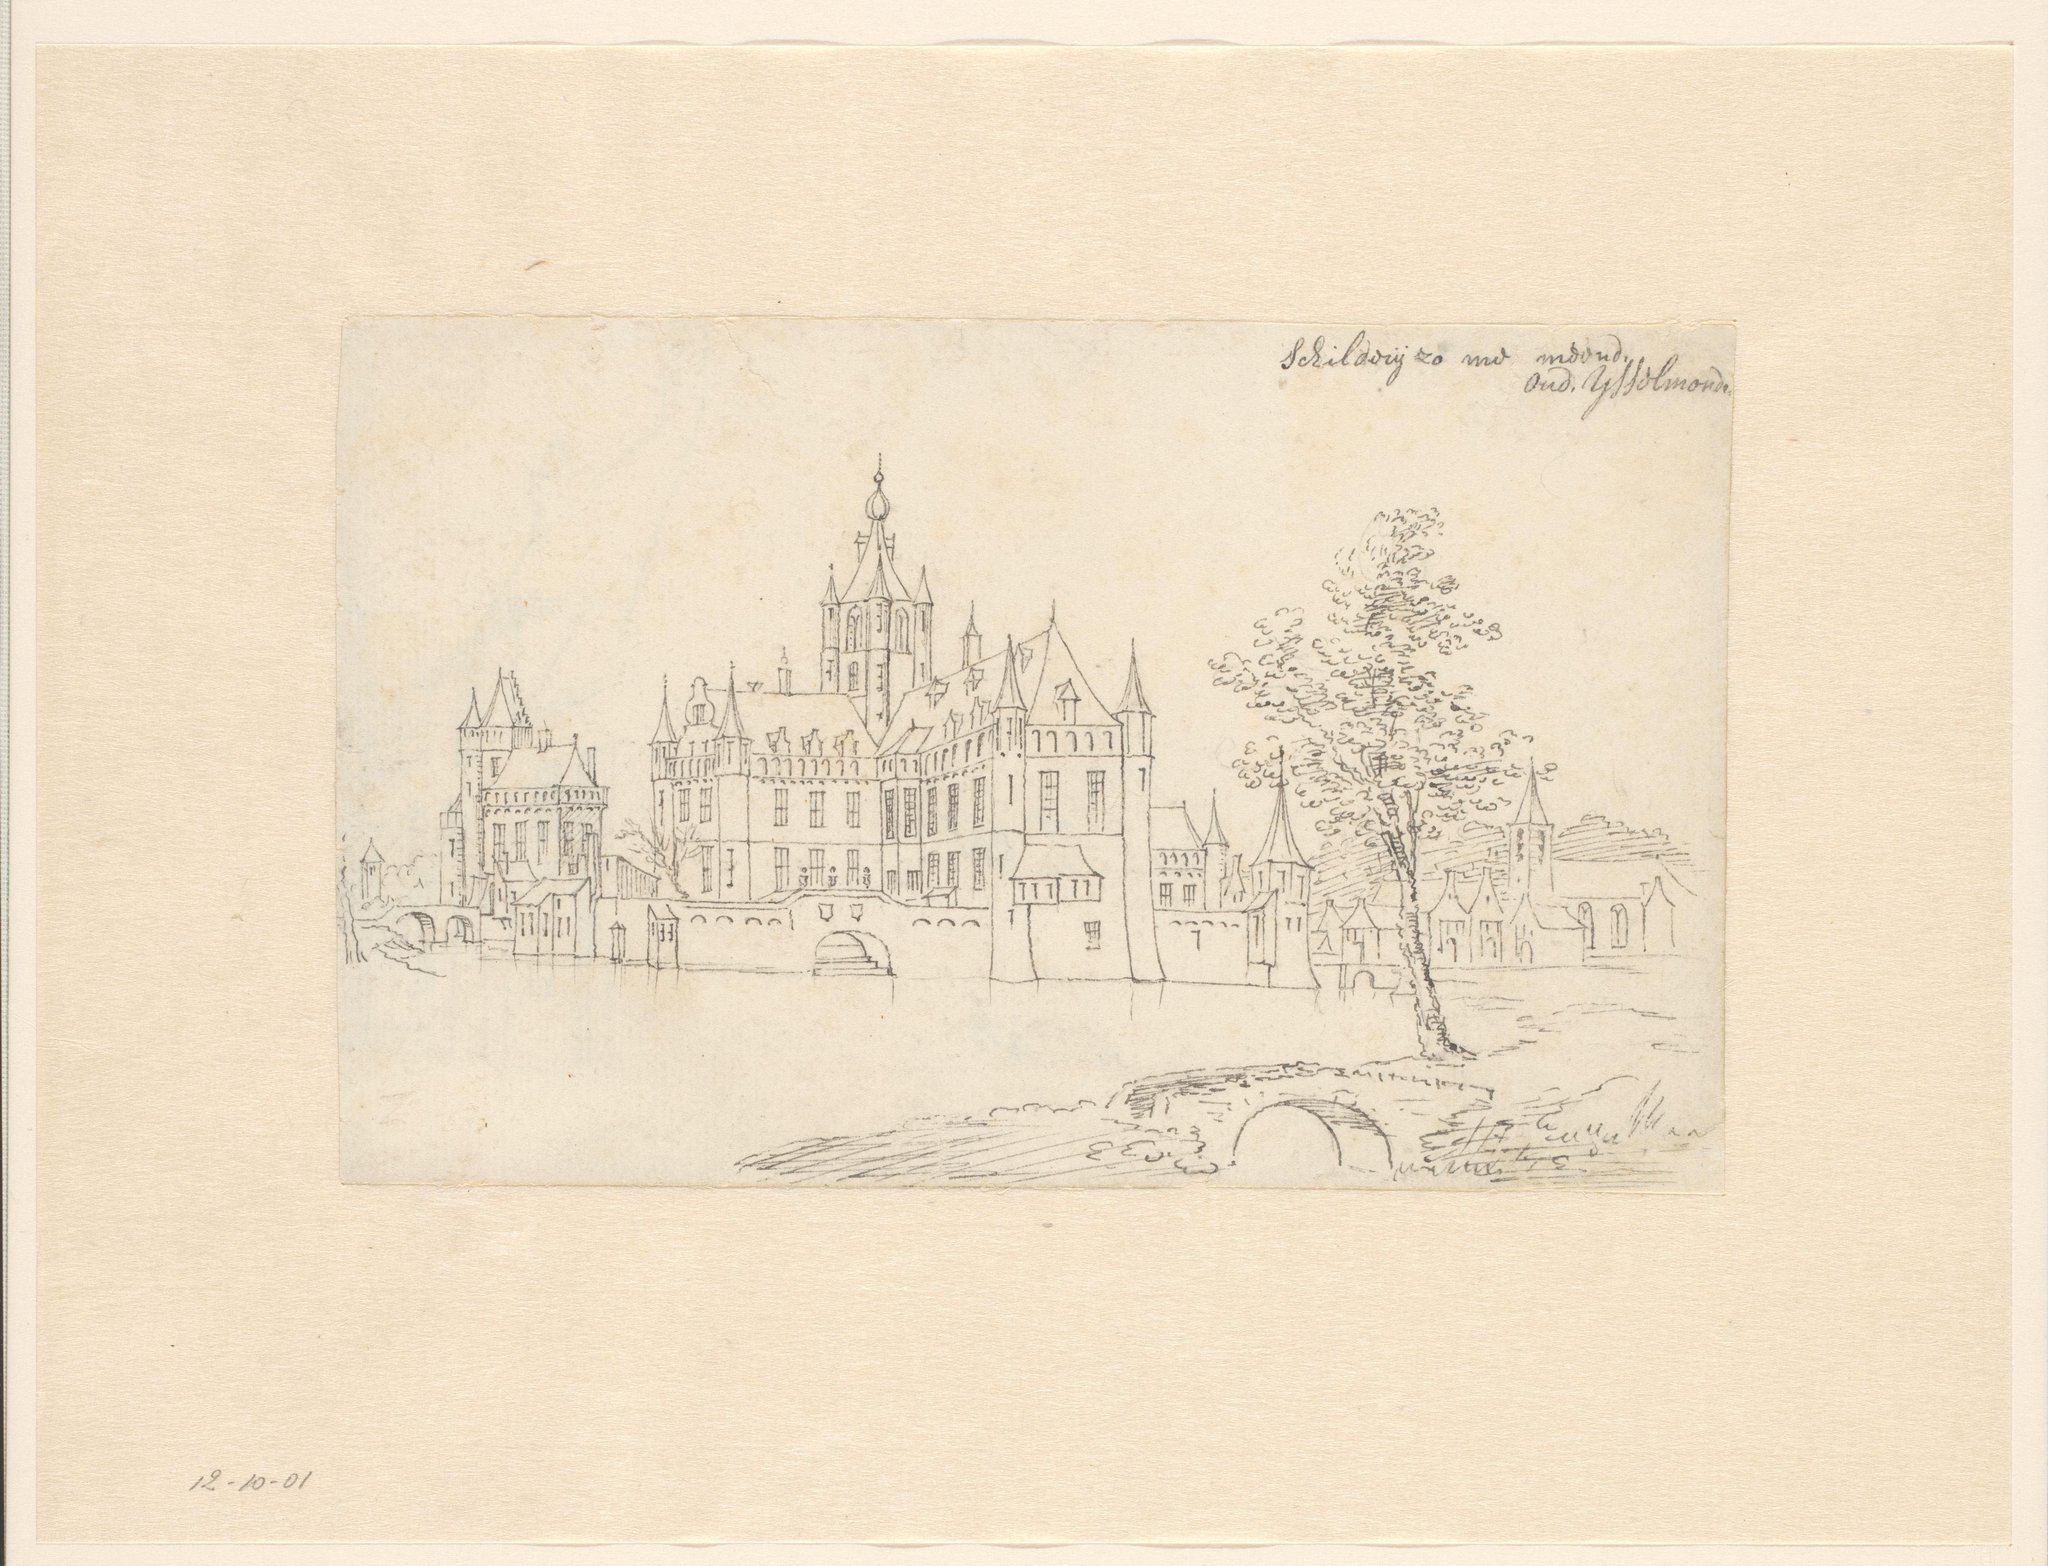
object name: drawing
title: Het kasteel IJsselmonde en het dorp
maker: cornelis pronk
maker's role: draughtsman, painter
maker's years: 1691-1759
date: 1720-1740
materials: ink, paper, pencil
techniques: pen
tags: castle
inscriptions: inscription: ‘Schilderij zo [....?] / Oud IJsselmonde’